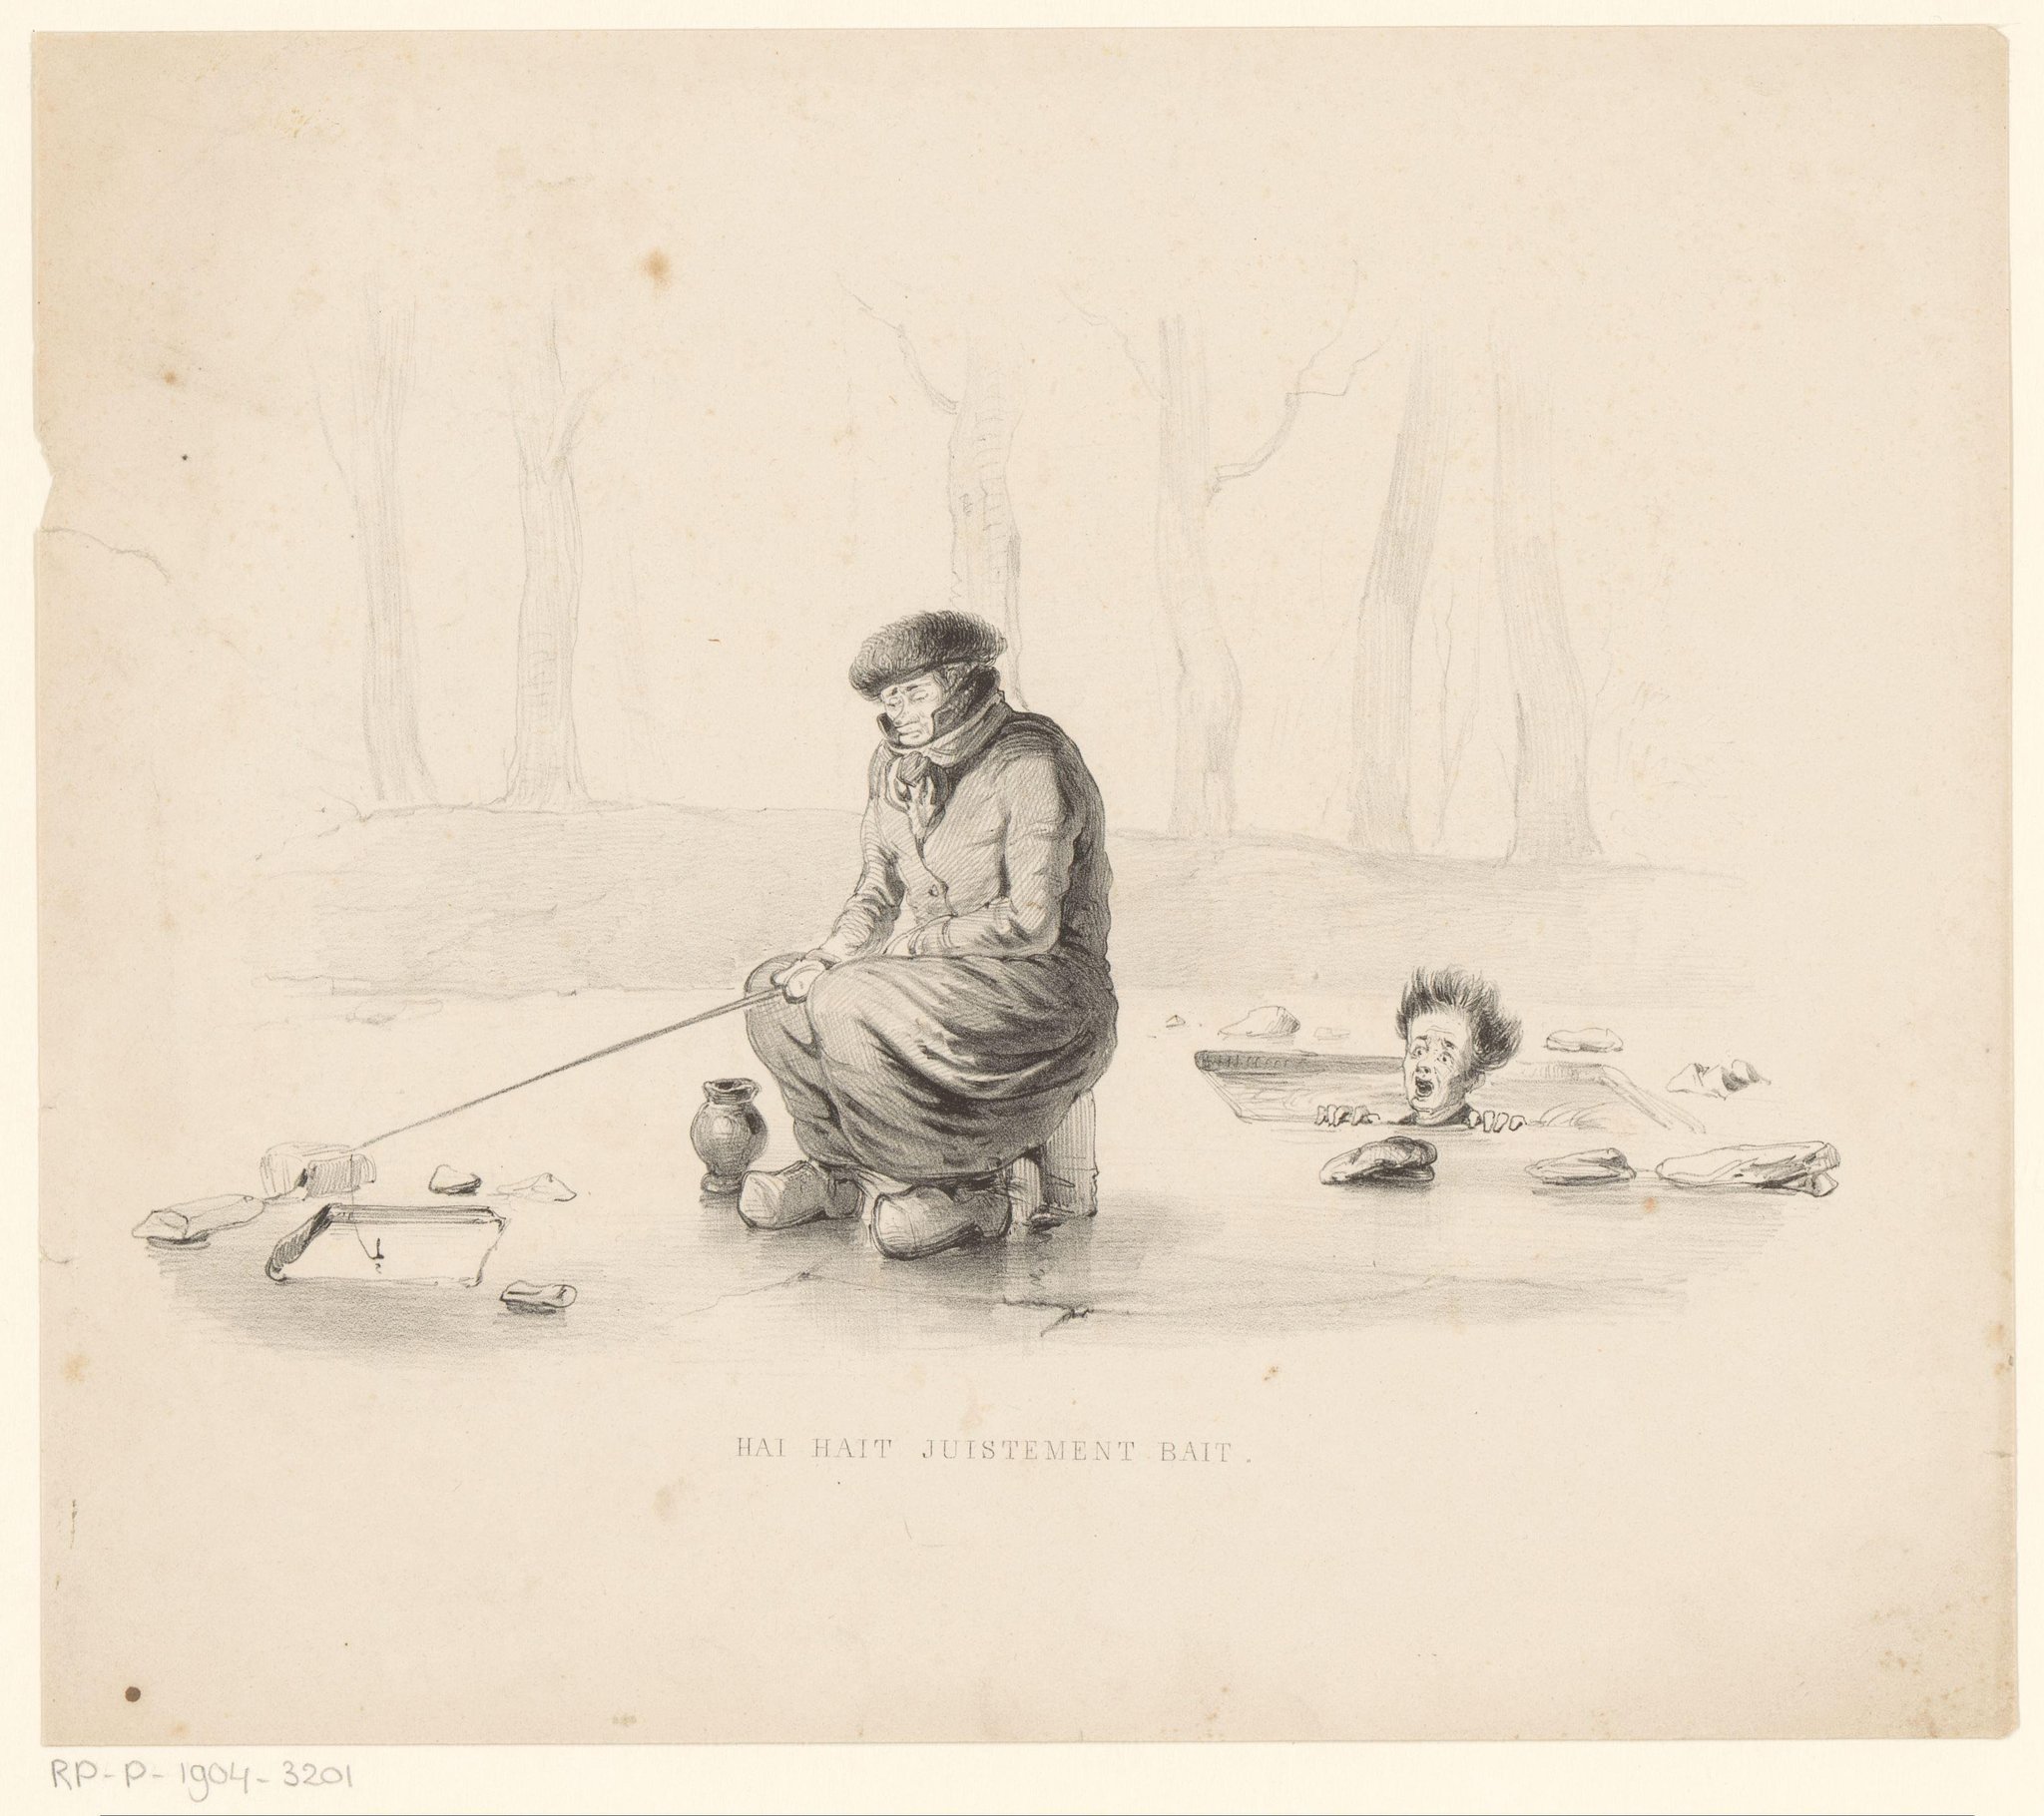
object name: print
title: Visser op het ijs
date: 1832-1897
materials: paper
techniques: lithograph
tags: fishing (sports)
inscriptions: collector's mark: Lugt 2228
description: Een vissende man zit op het ijs. Achter hem verschijnt een jongeman uit een wak.